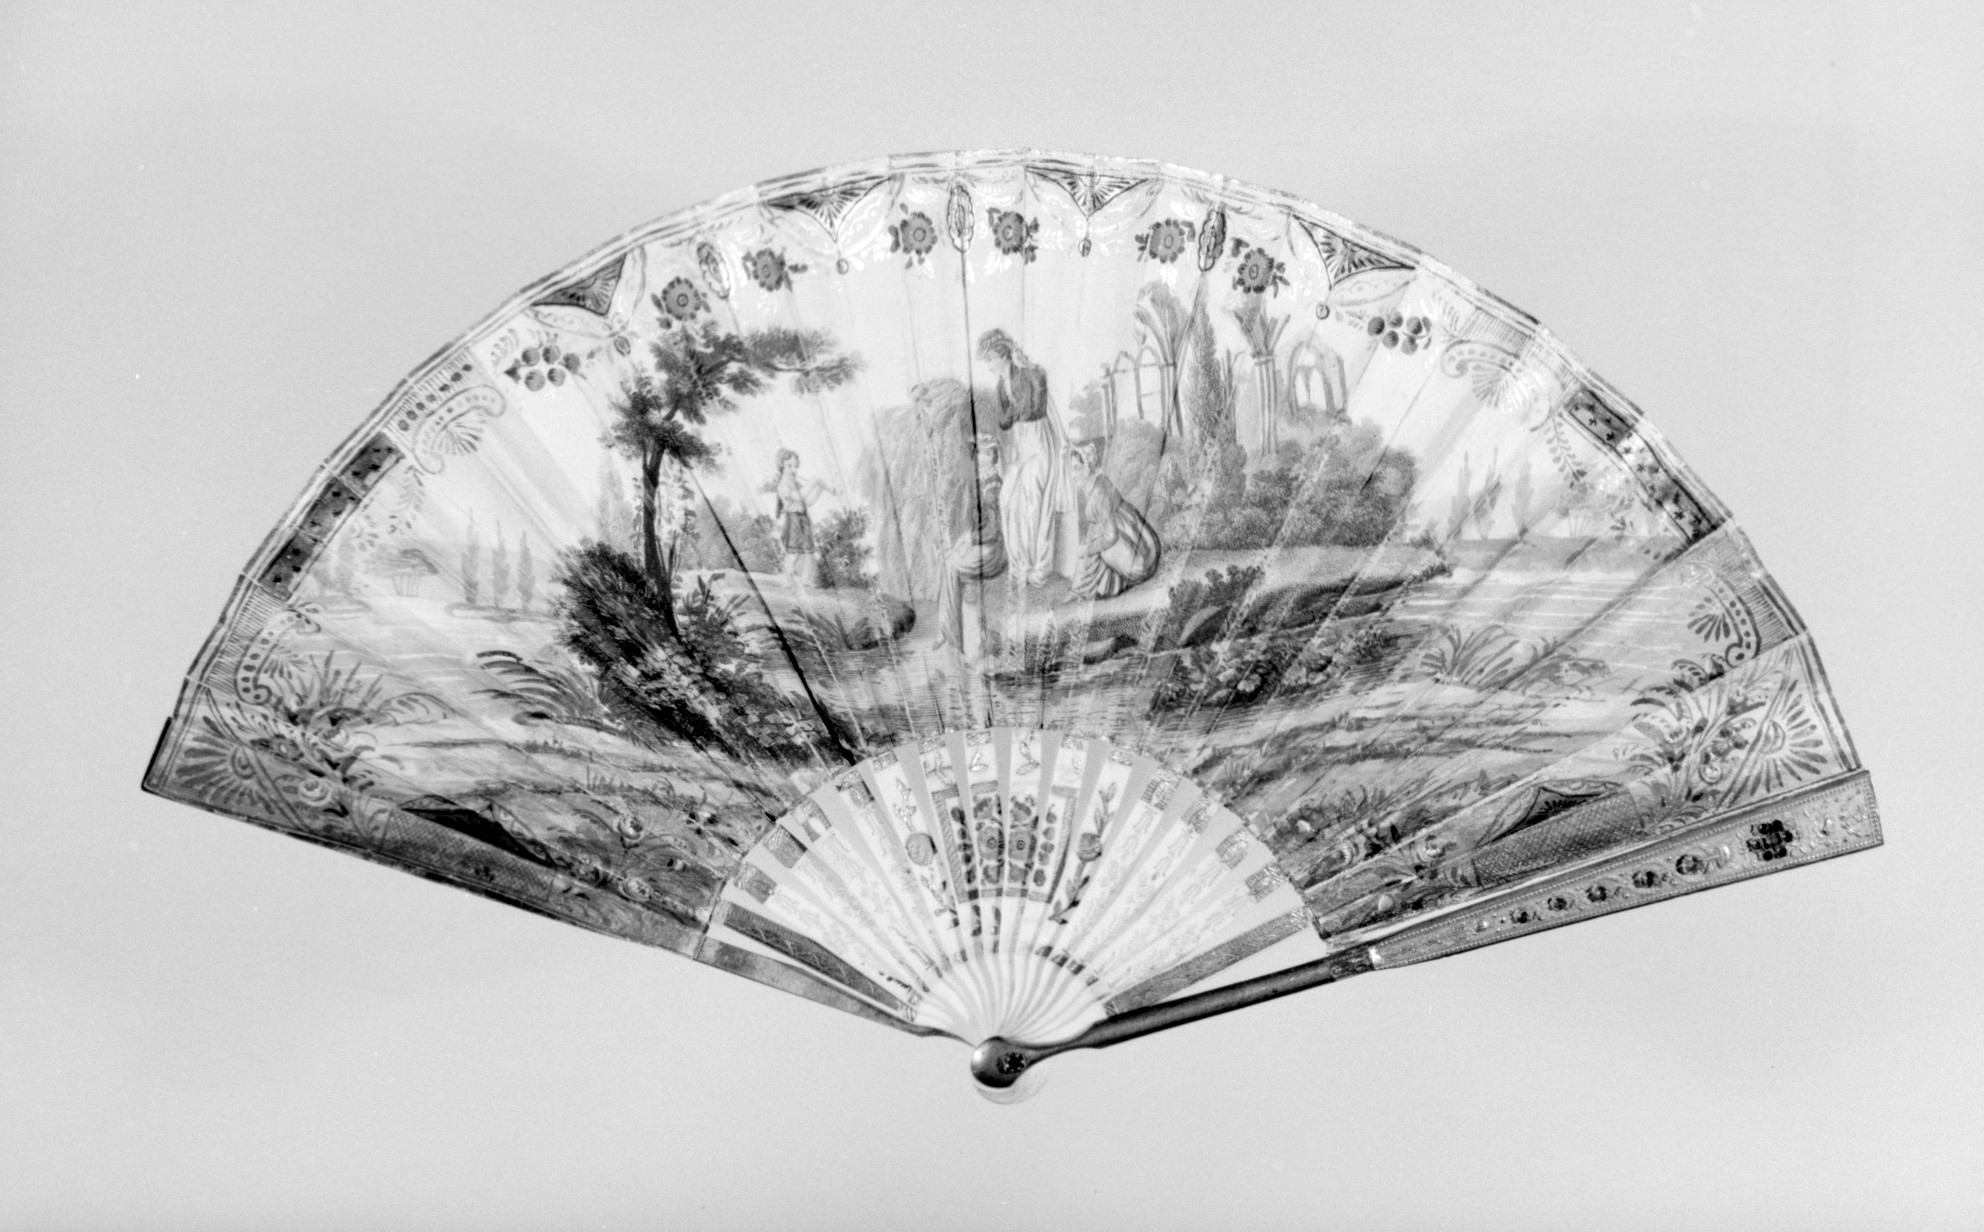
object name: fan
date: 1825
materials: foil, glass, ivory, metal, paint, paper, parchment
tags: women